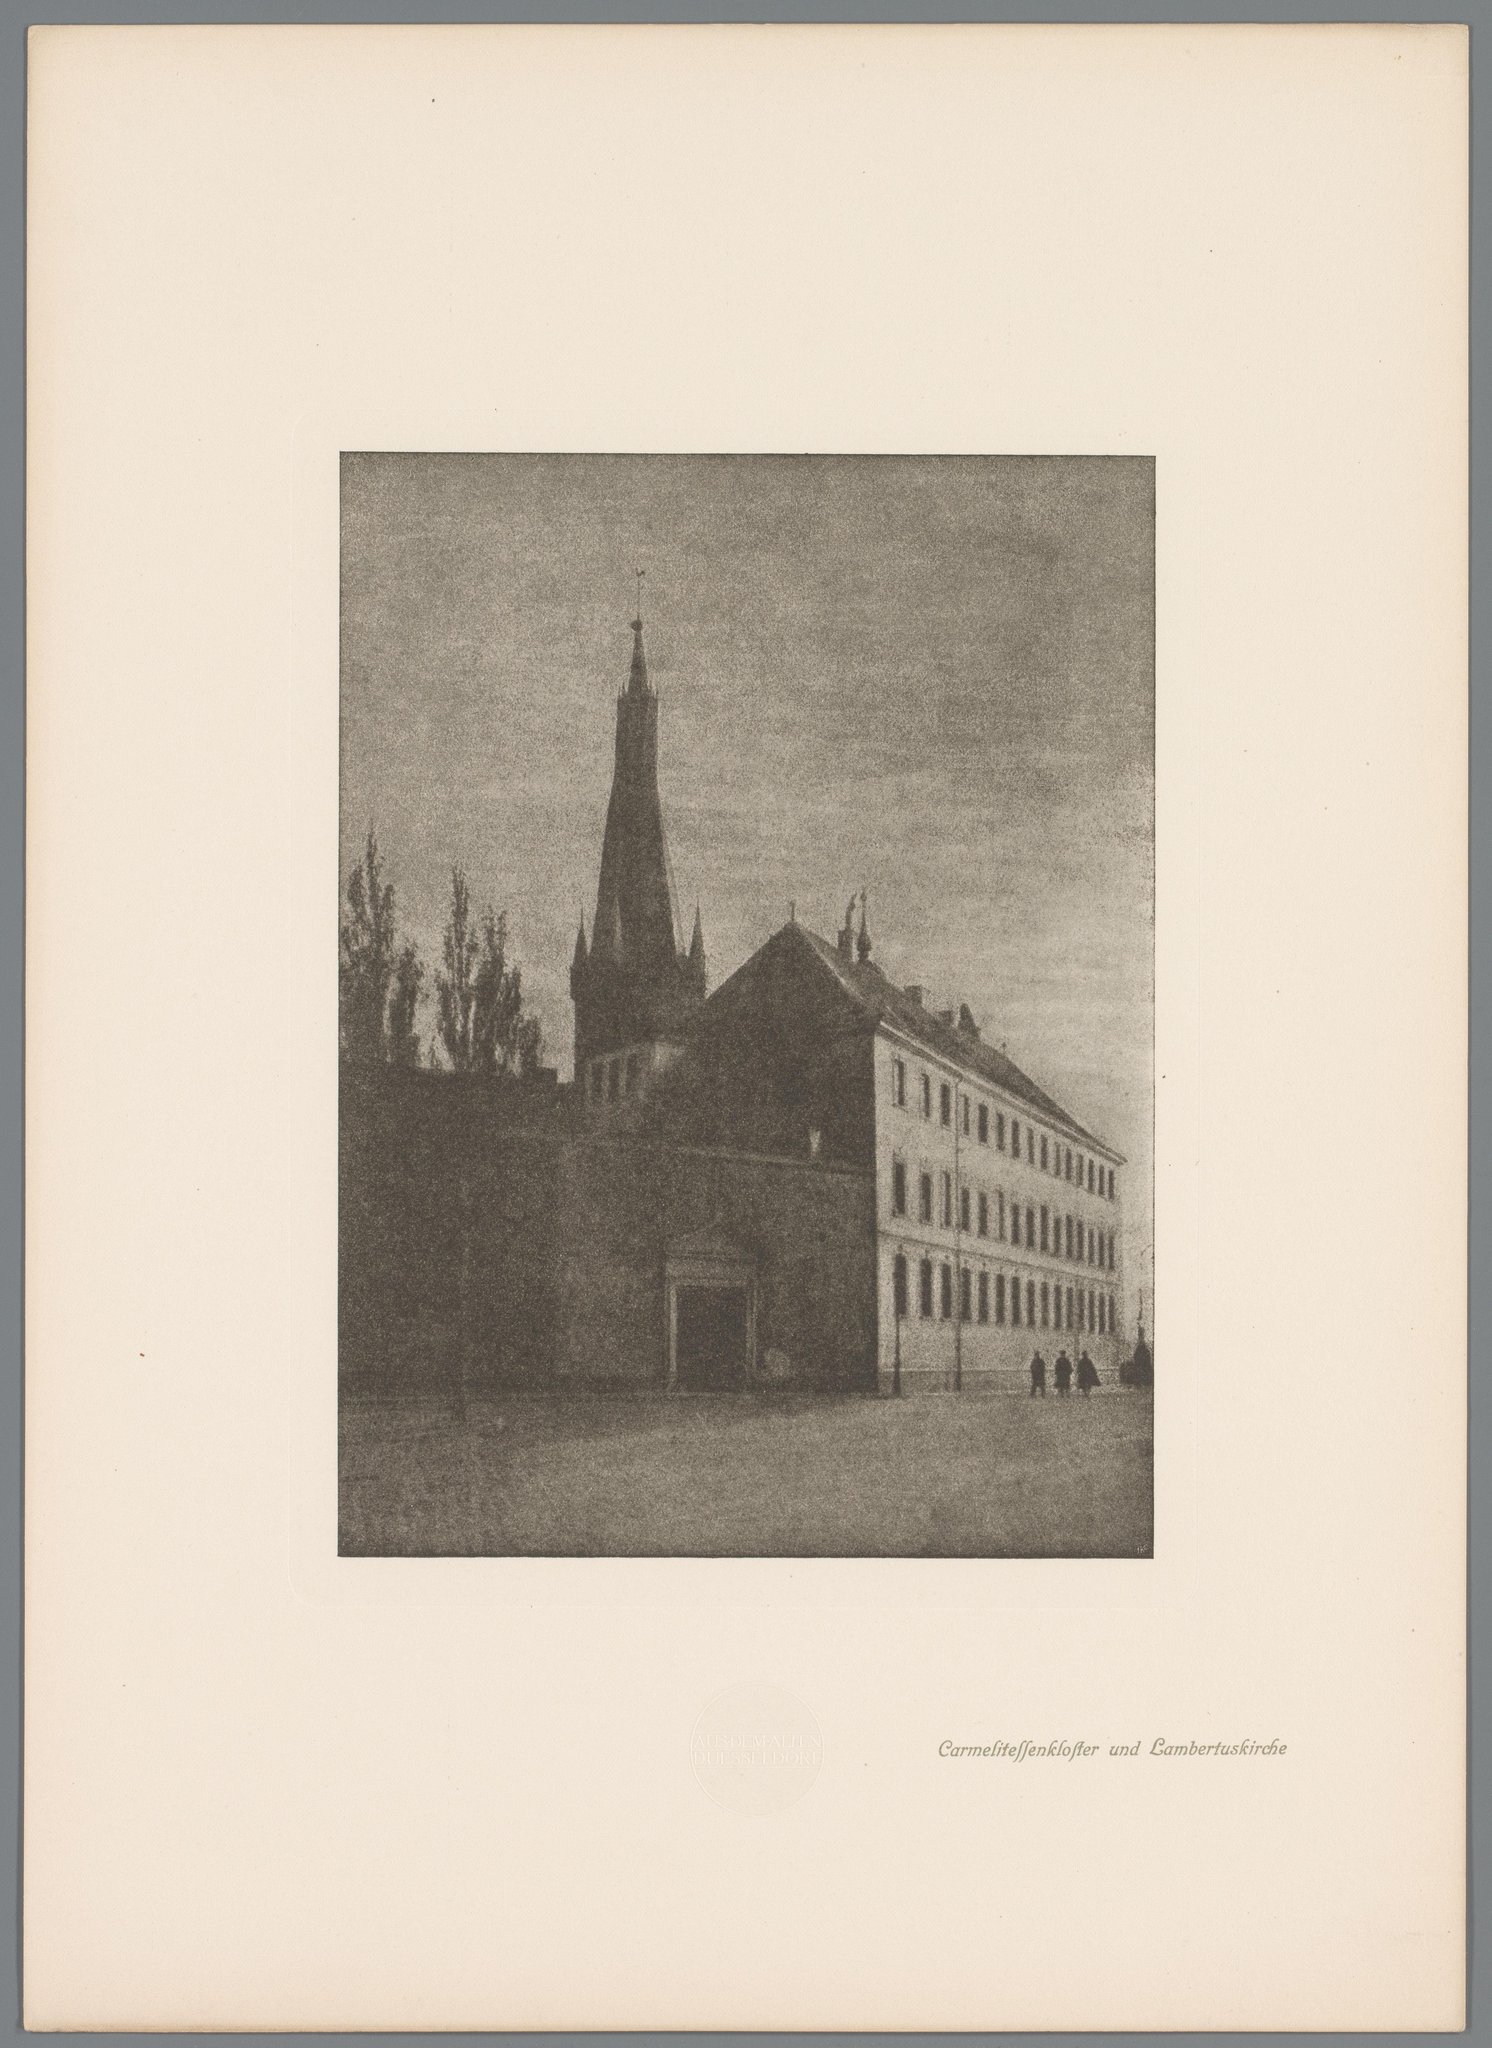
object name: page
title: Carmelitessenkloster und Lambertuskirche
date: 1902-1907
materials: paper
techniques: autotype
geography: offenbach am main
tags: abbey, monastery, convent ~ roman catholic church, church (exterior)